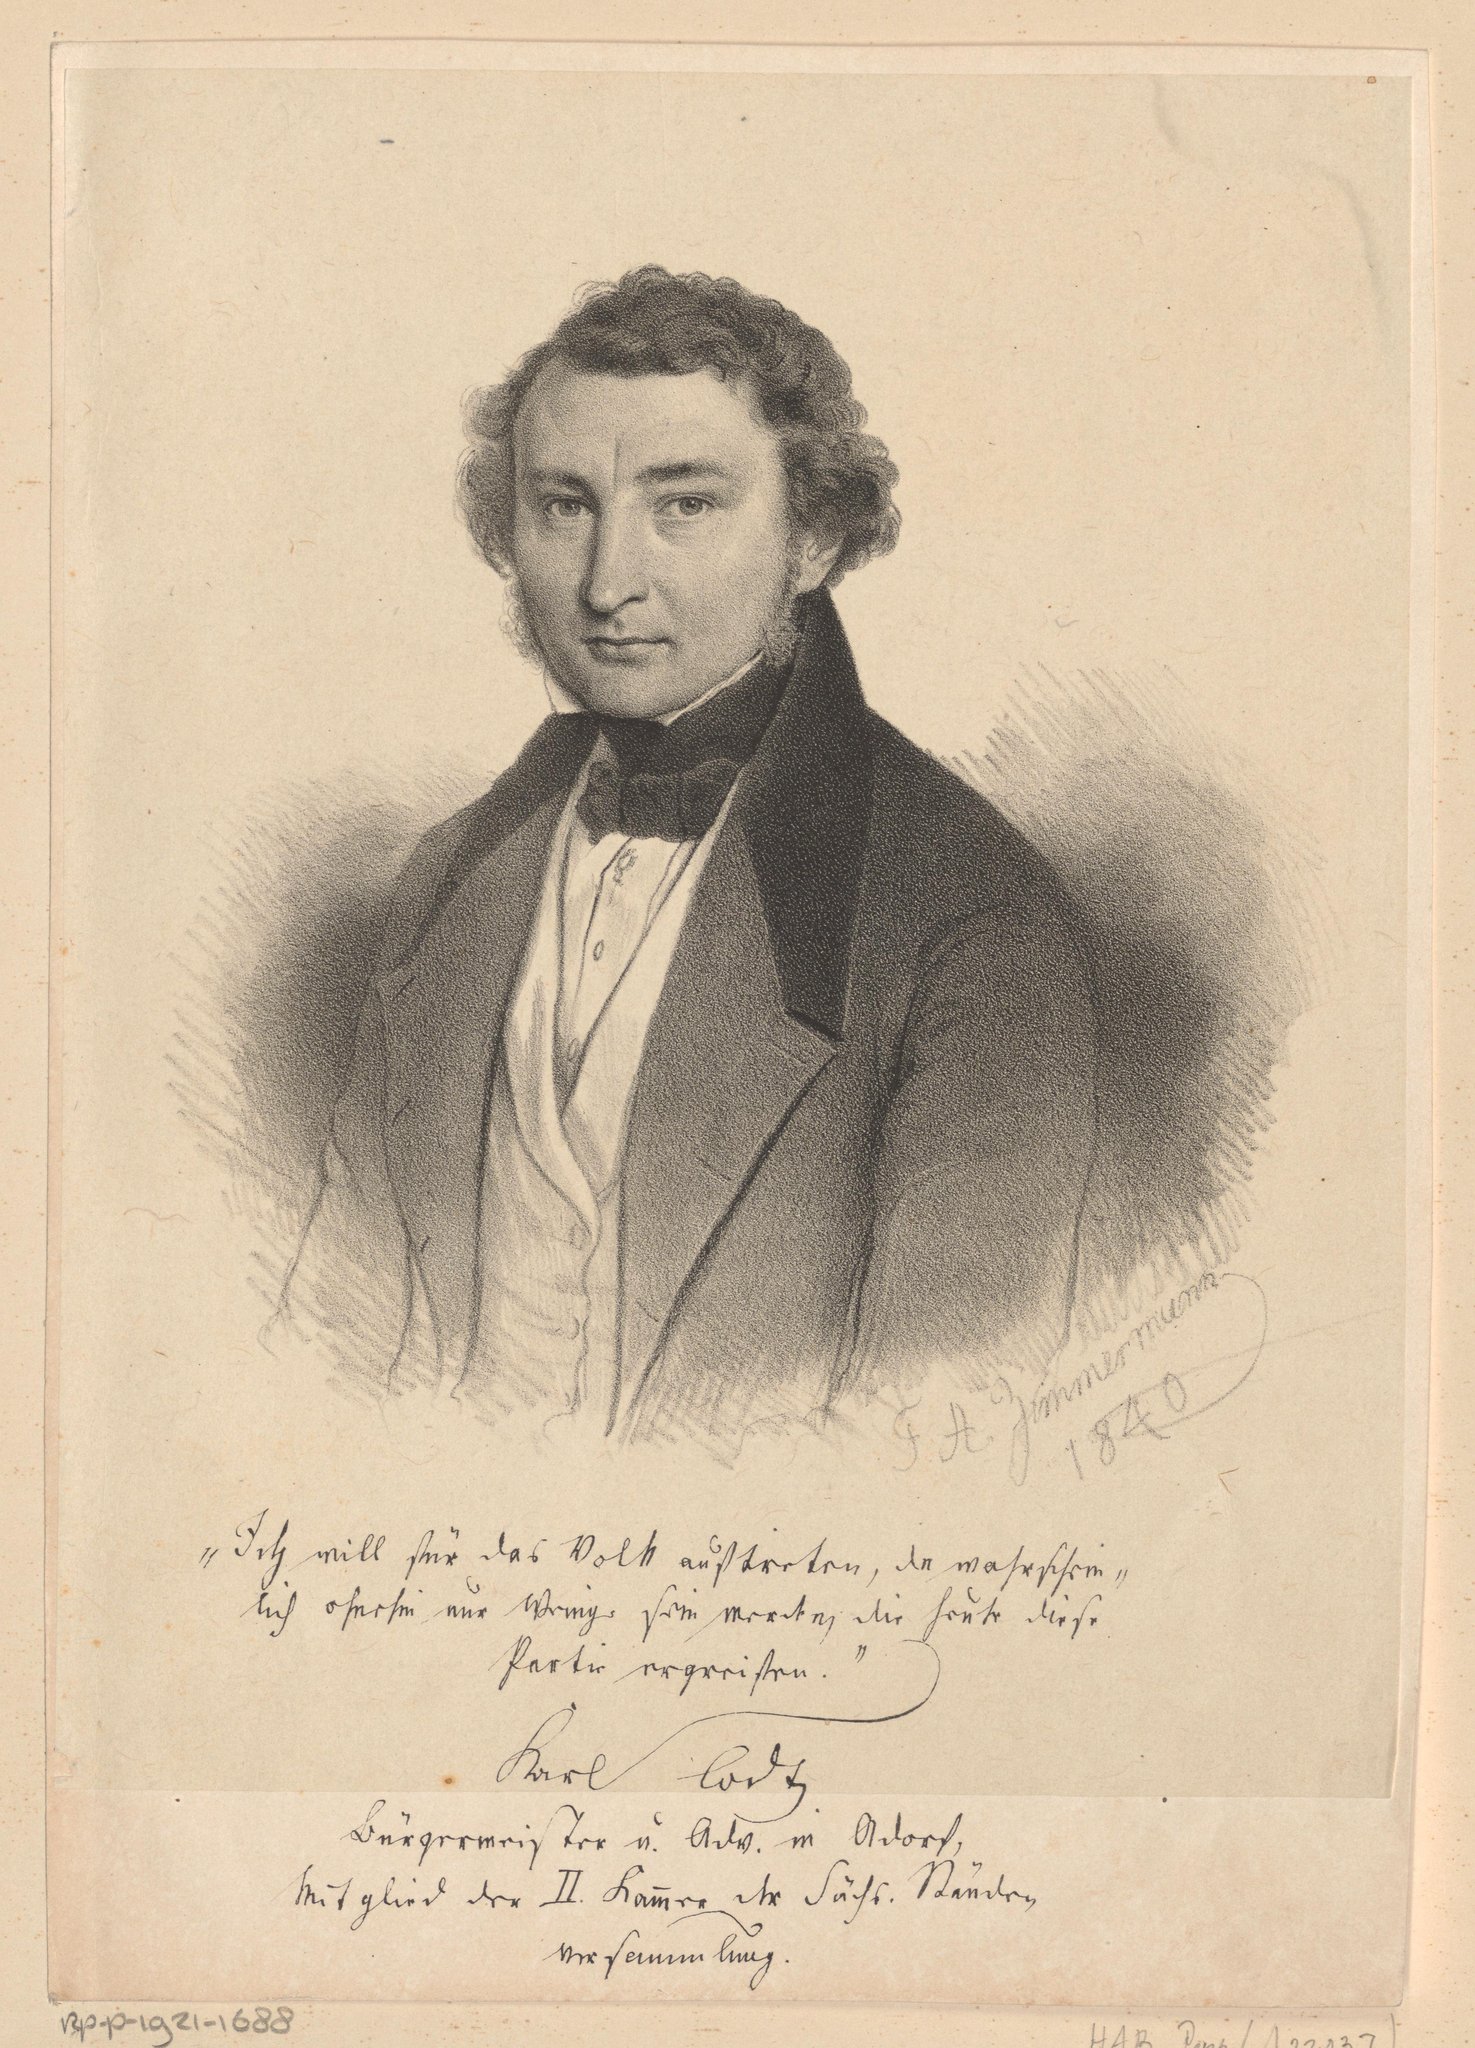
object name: print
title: Portret van Karl Gotthelf Todt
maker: friedrich august zimmermann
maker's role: print maker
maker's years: 1805-1876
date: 1840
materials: paper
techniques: lithograph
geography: dresden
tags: historical persons, politician, e.g. party leader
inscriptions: collector's mark: Lugt 2233